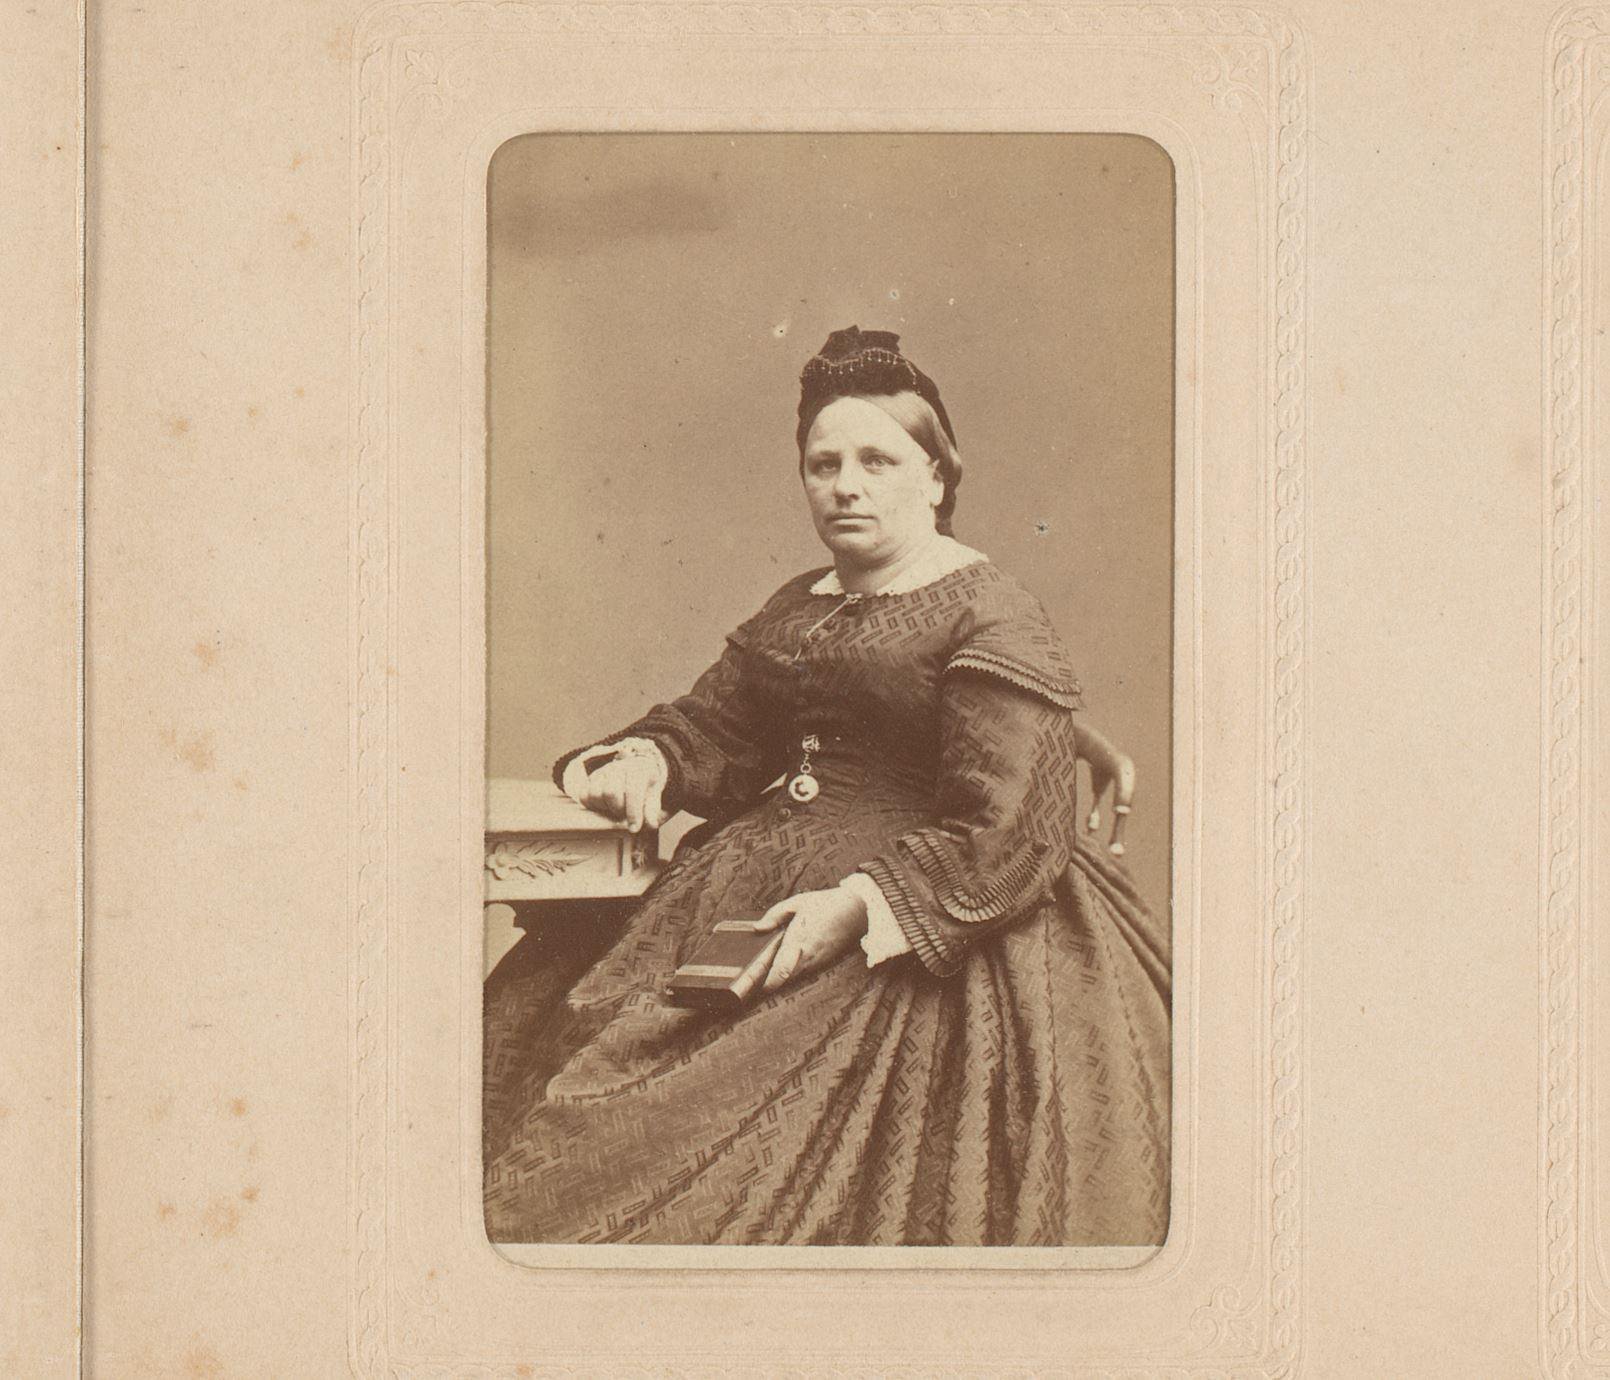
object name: photograph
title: Portret van een zittende vrouw met boek in de hand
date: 1864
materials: cardboard, photographic support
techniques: albumen print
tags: sitting figure - aa - female human figure, historical persons - bb - woman, book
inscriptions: annotation: ‘AK/ [...]’, inscription: ‘M. L. Winter/ Photograph/ PRAG & CARLSBAD.’